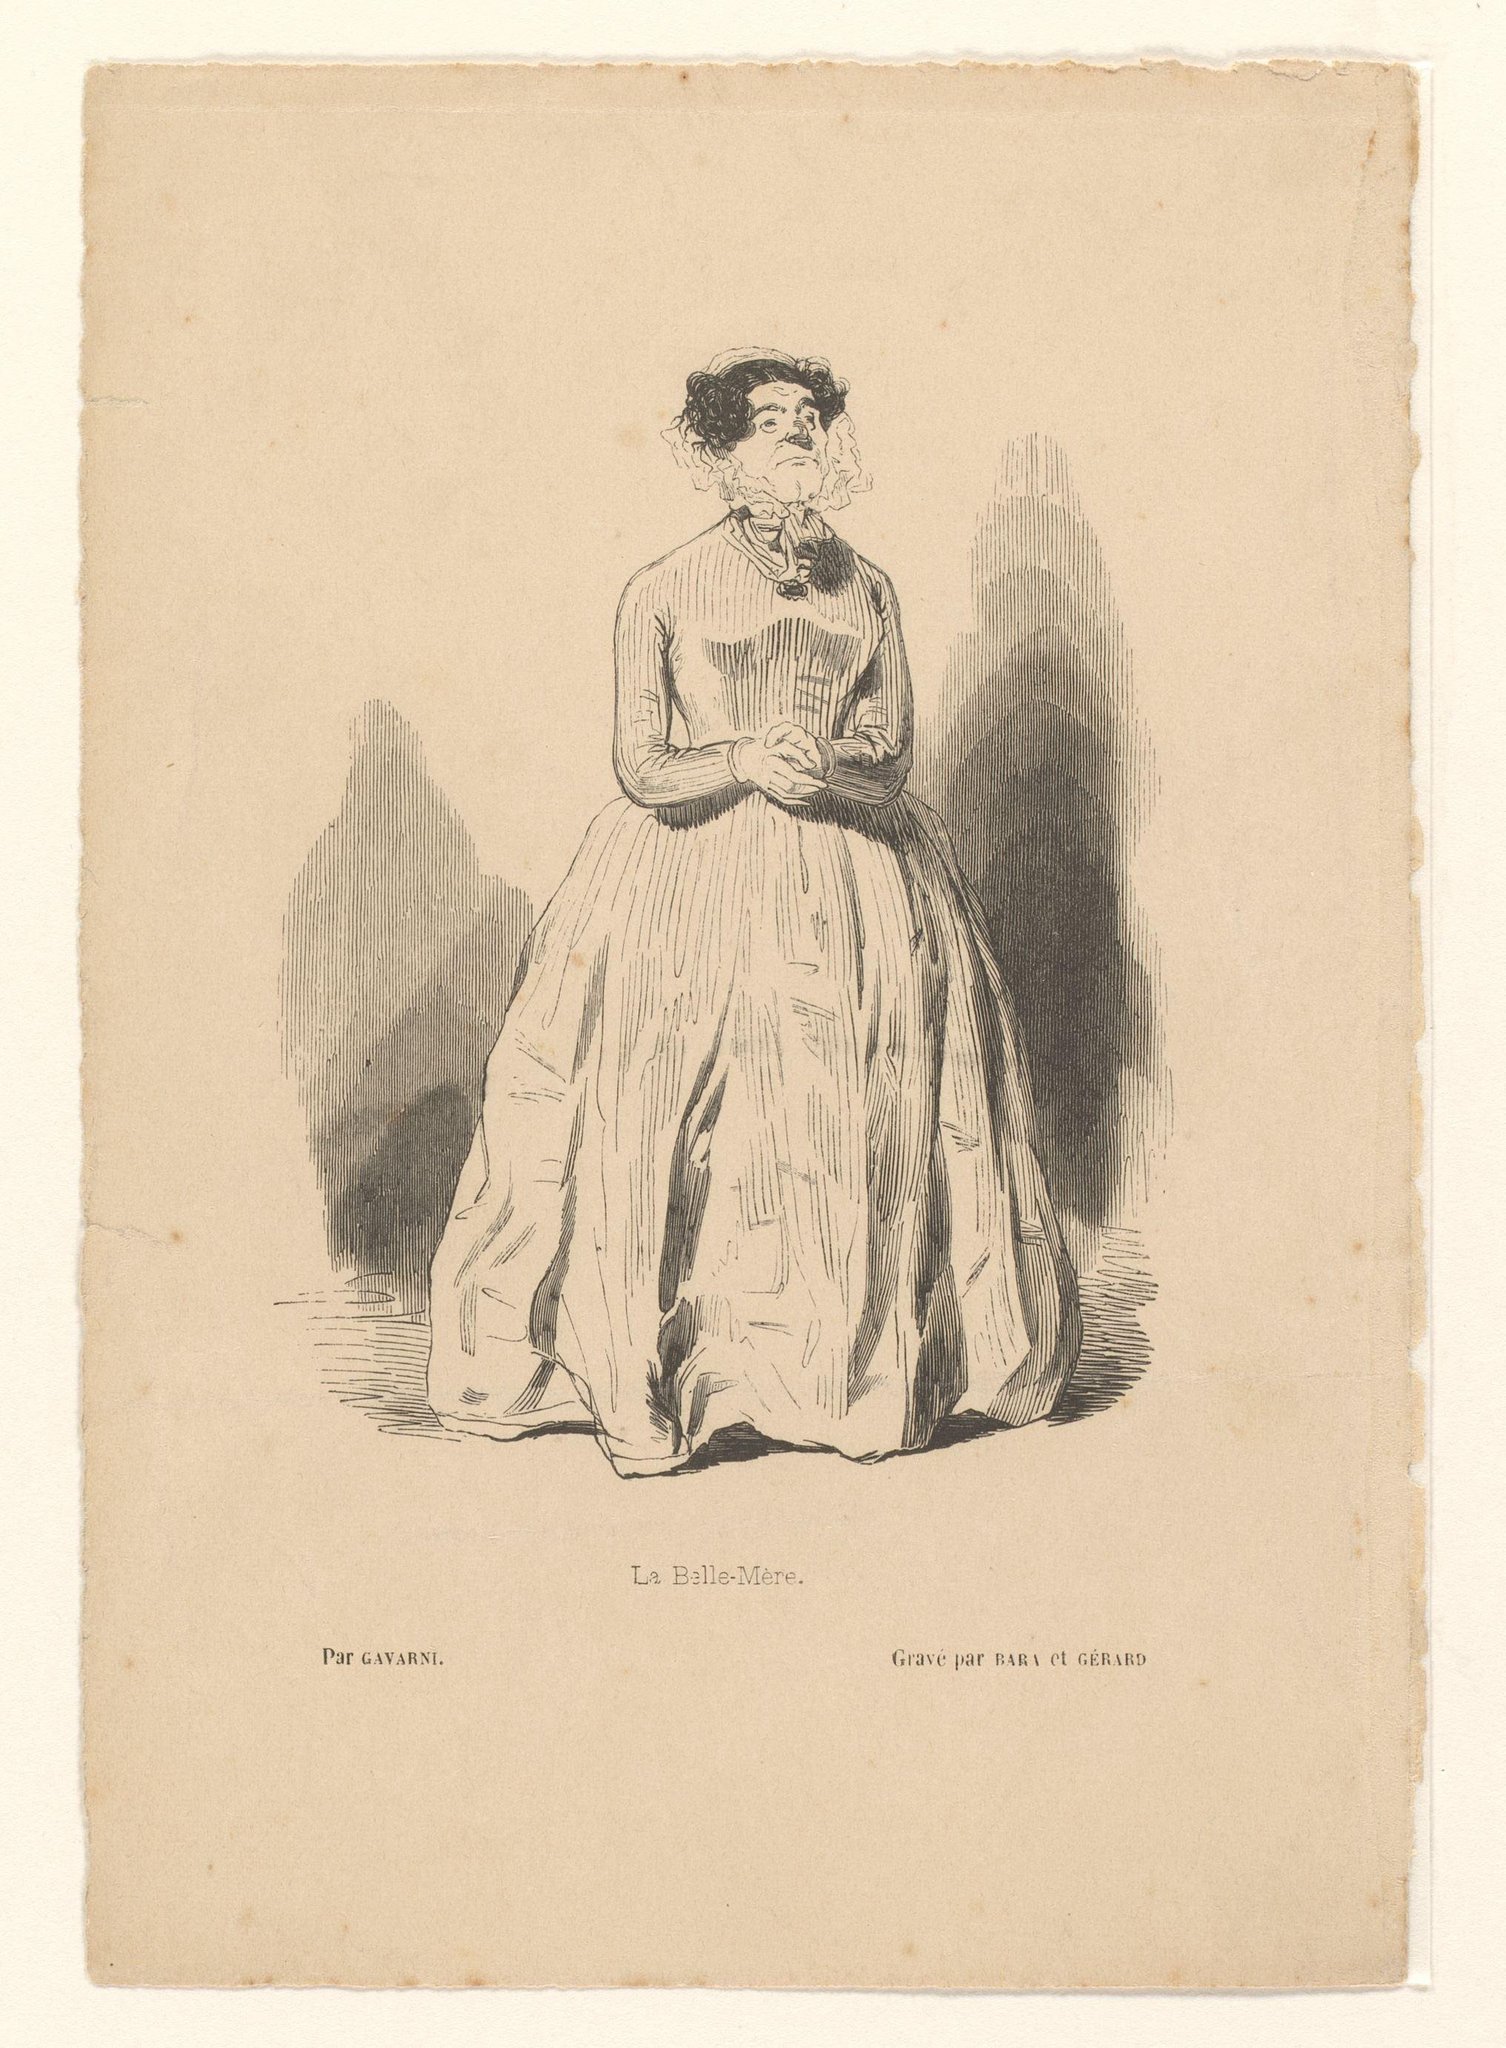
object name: print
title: La Belle-Mère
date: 1830-1862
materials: paper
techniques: engraving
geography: france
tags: paris, honoré de balzac, female literary characters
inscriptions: signature: ‘Gravé par Bara et Gérard’